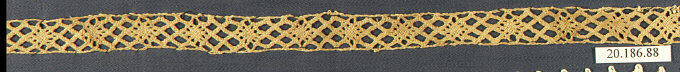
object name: insertion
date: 1501-1600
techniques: lace